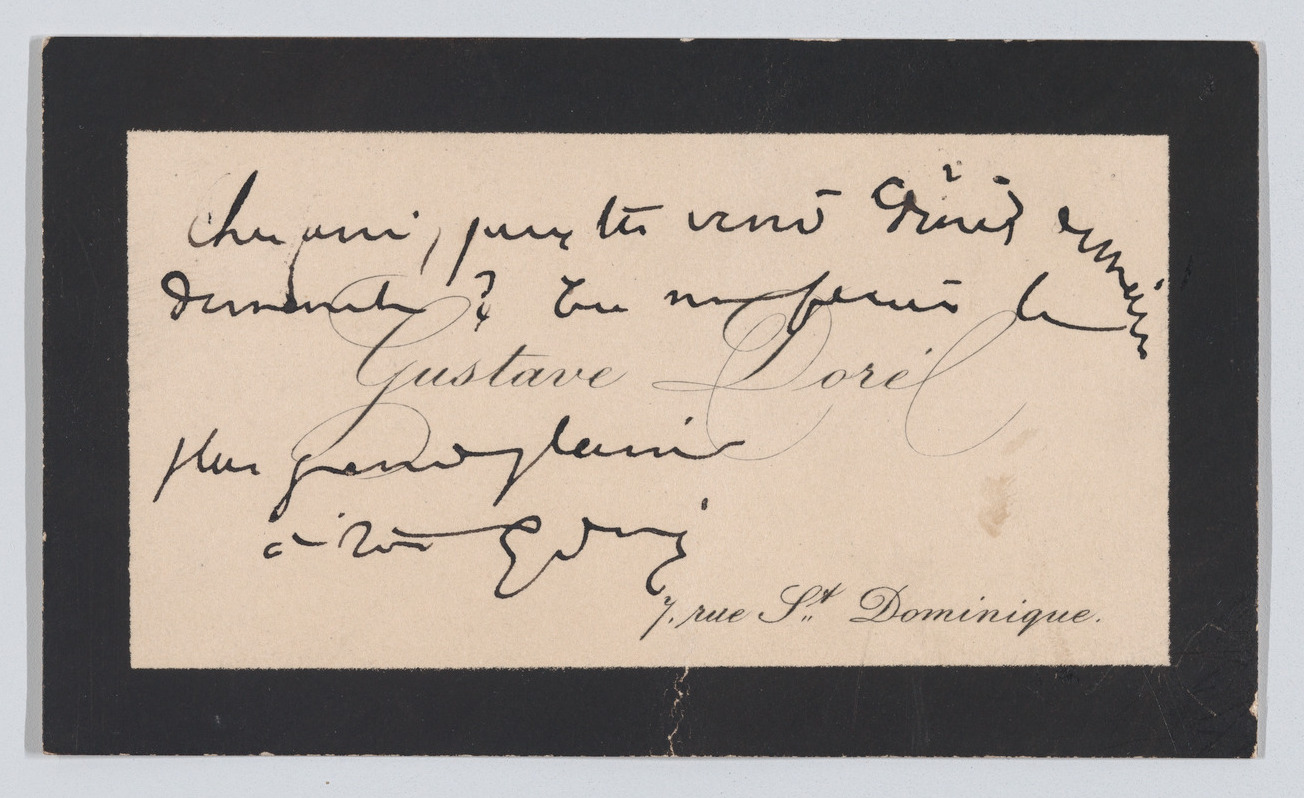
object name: print, calling card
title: Gustave Doré, calling card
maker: Anonymous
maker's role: artist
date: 1849-1883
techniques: engraving